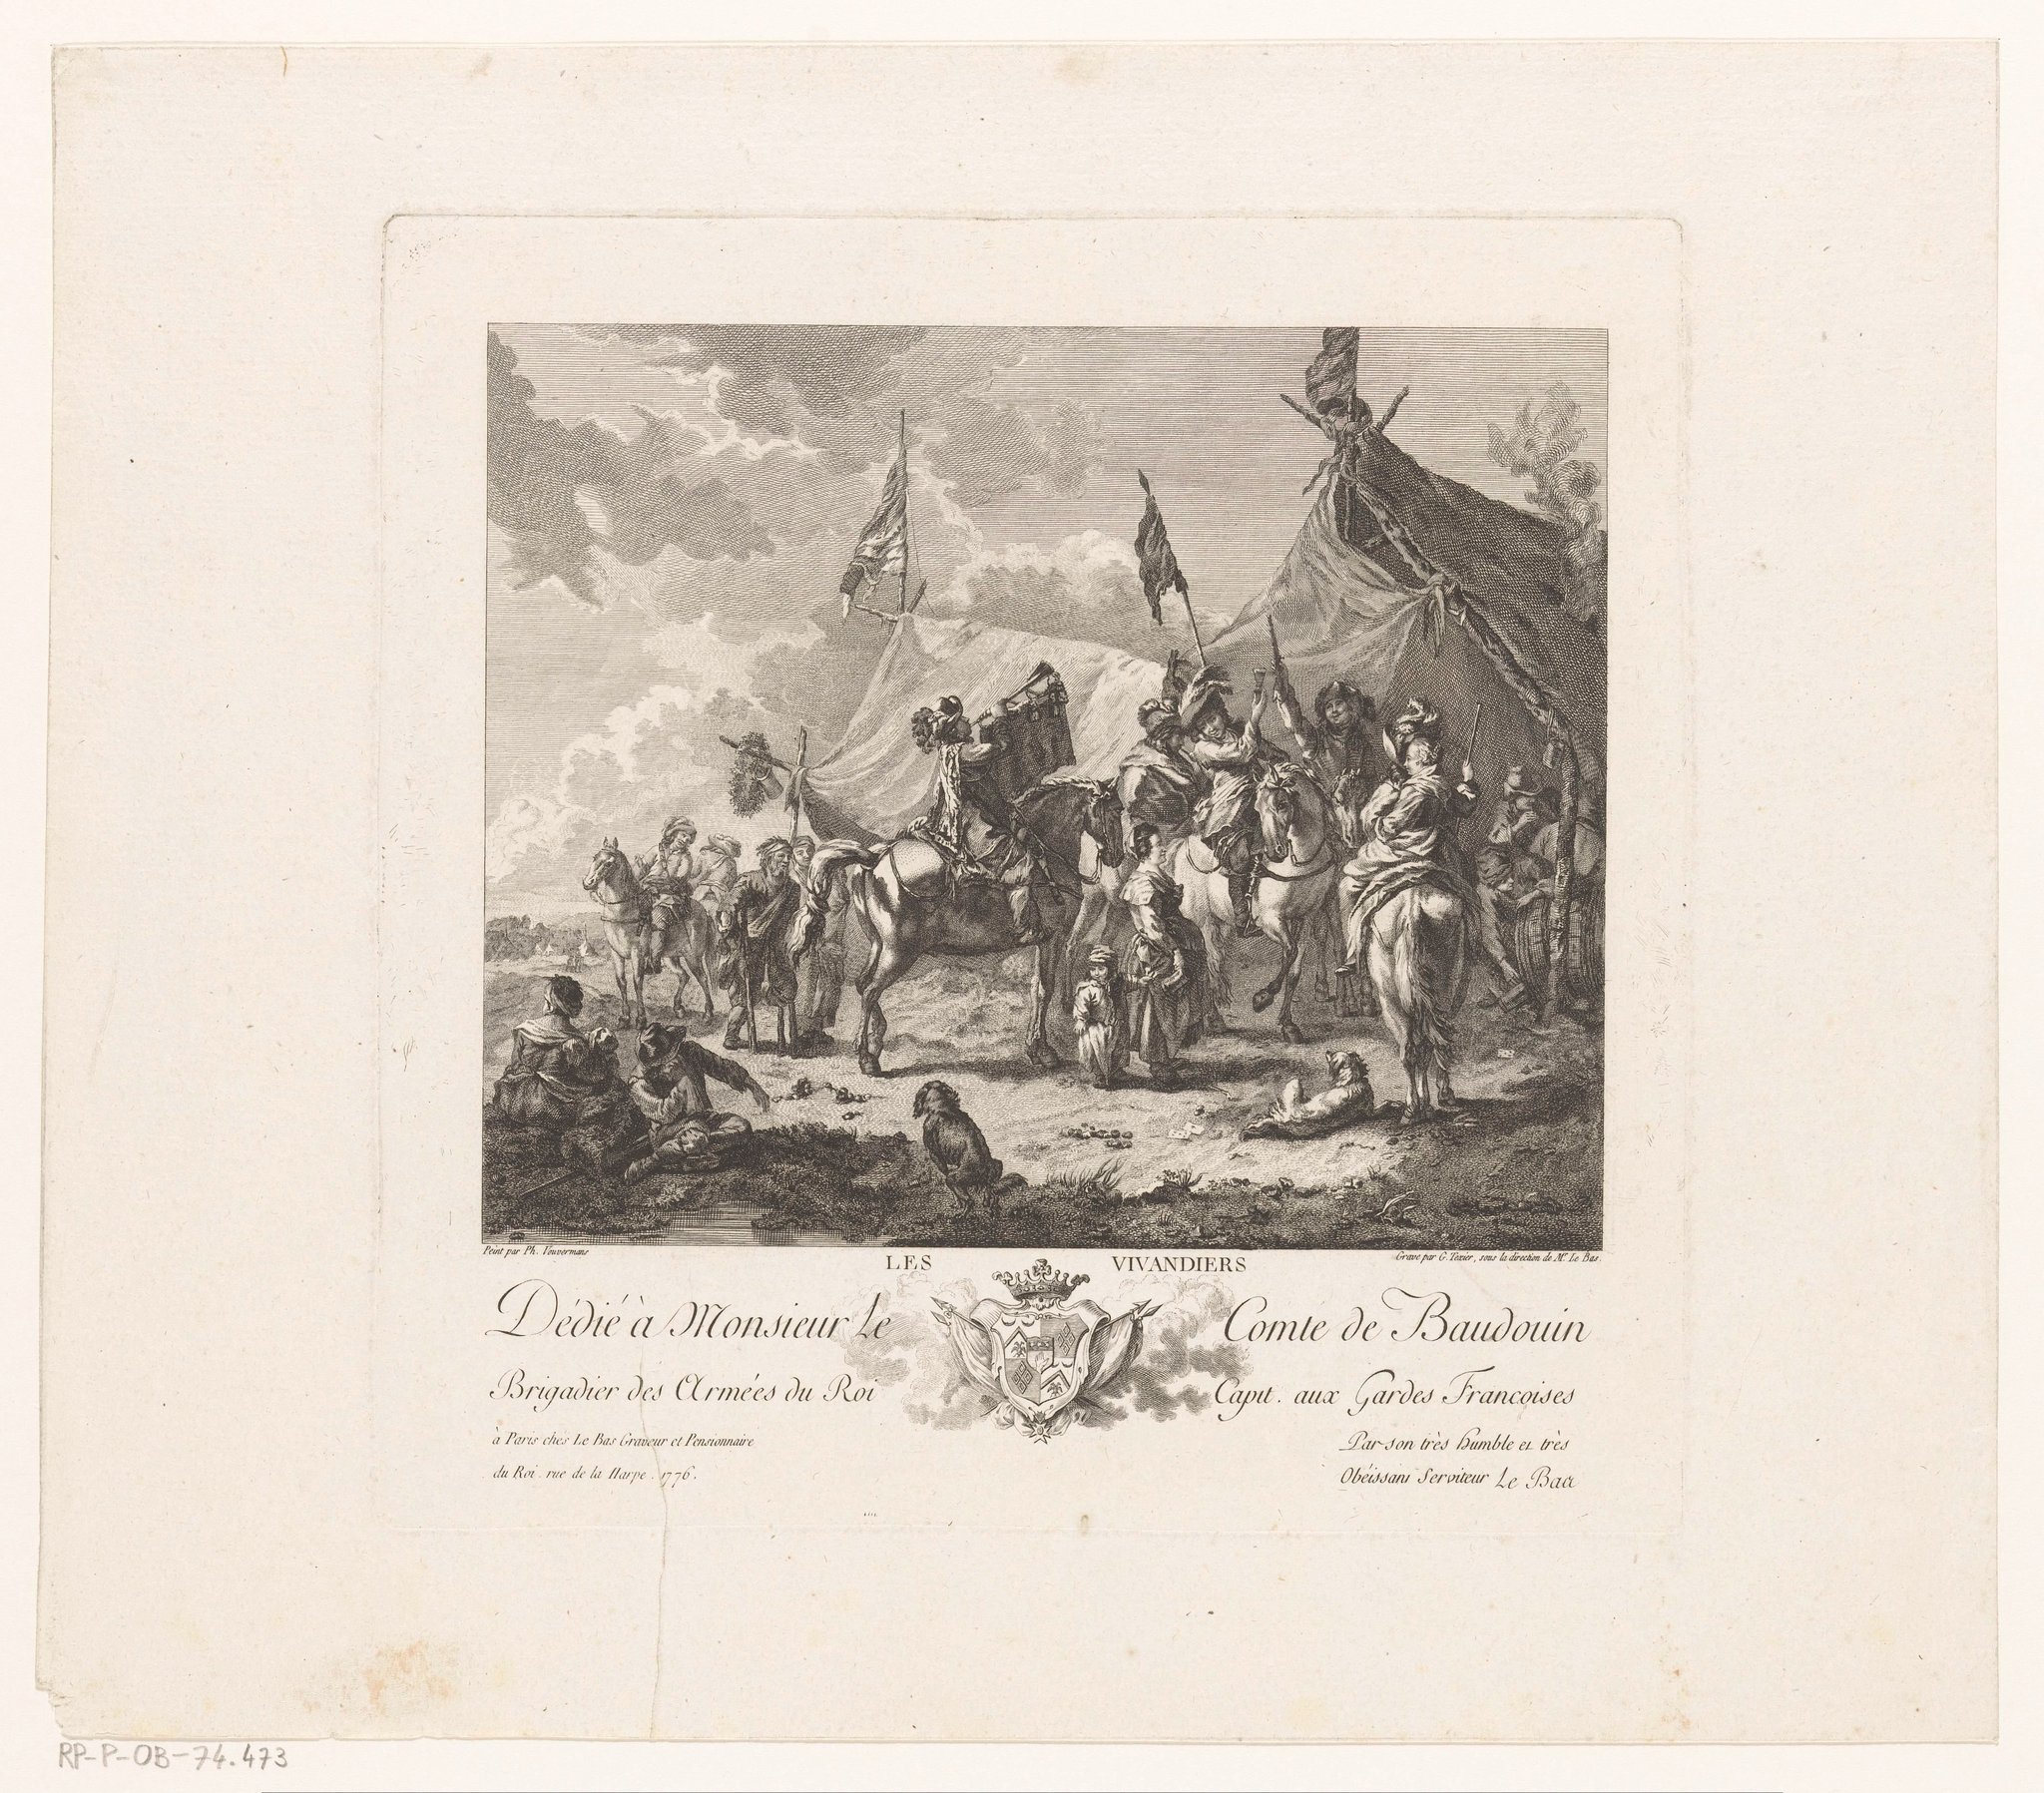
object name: print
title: Portret van Jost von Silenen in ovaal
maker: g. texier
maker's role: print maker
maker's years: 1750-1824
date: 1760-1824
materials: paper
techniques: engraving, etching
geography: france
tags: france, hierarchy of jurisdiction ~ roman catholic church, historical persons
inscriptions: collector's mark: Lugt 2228